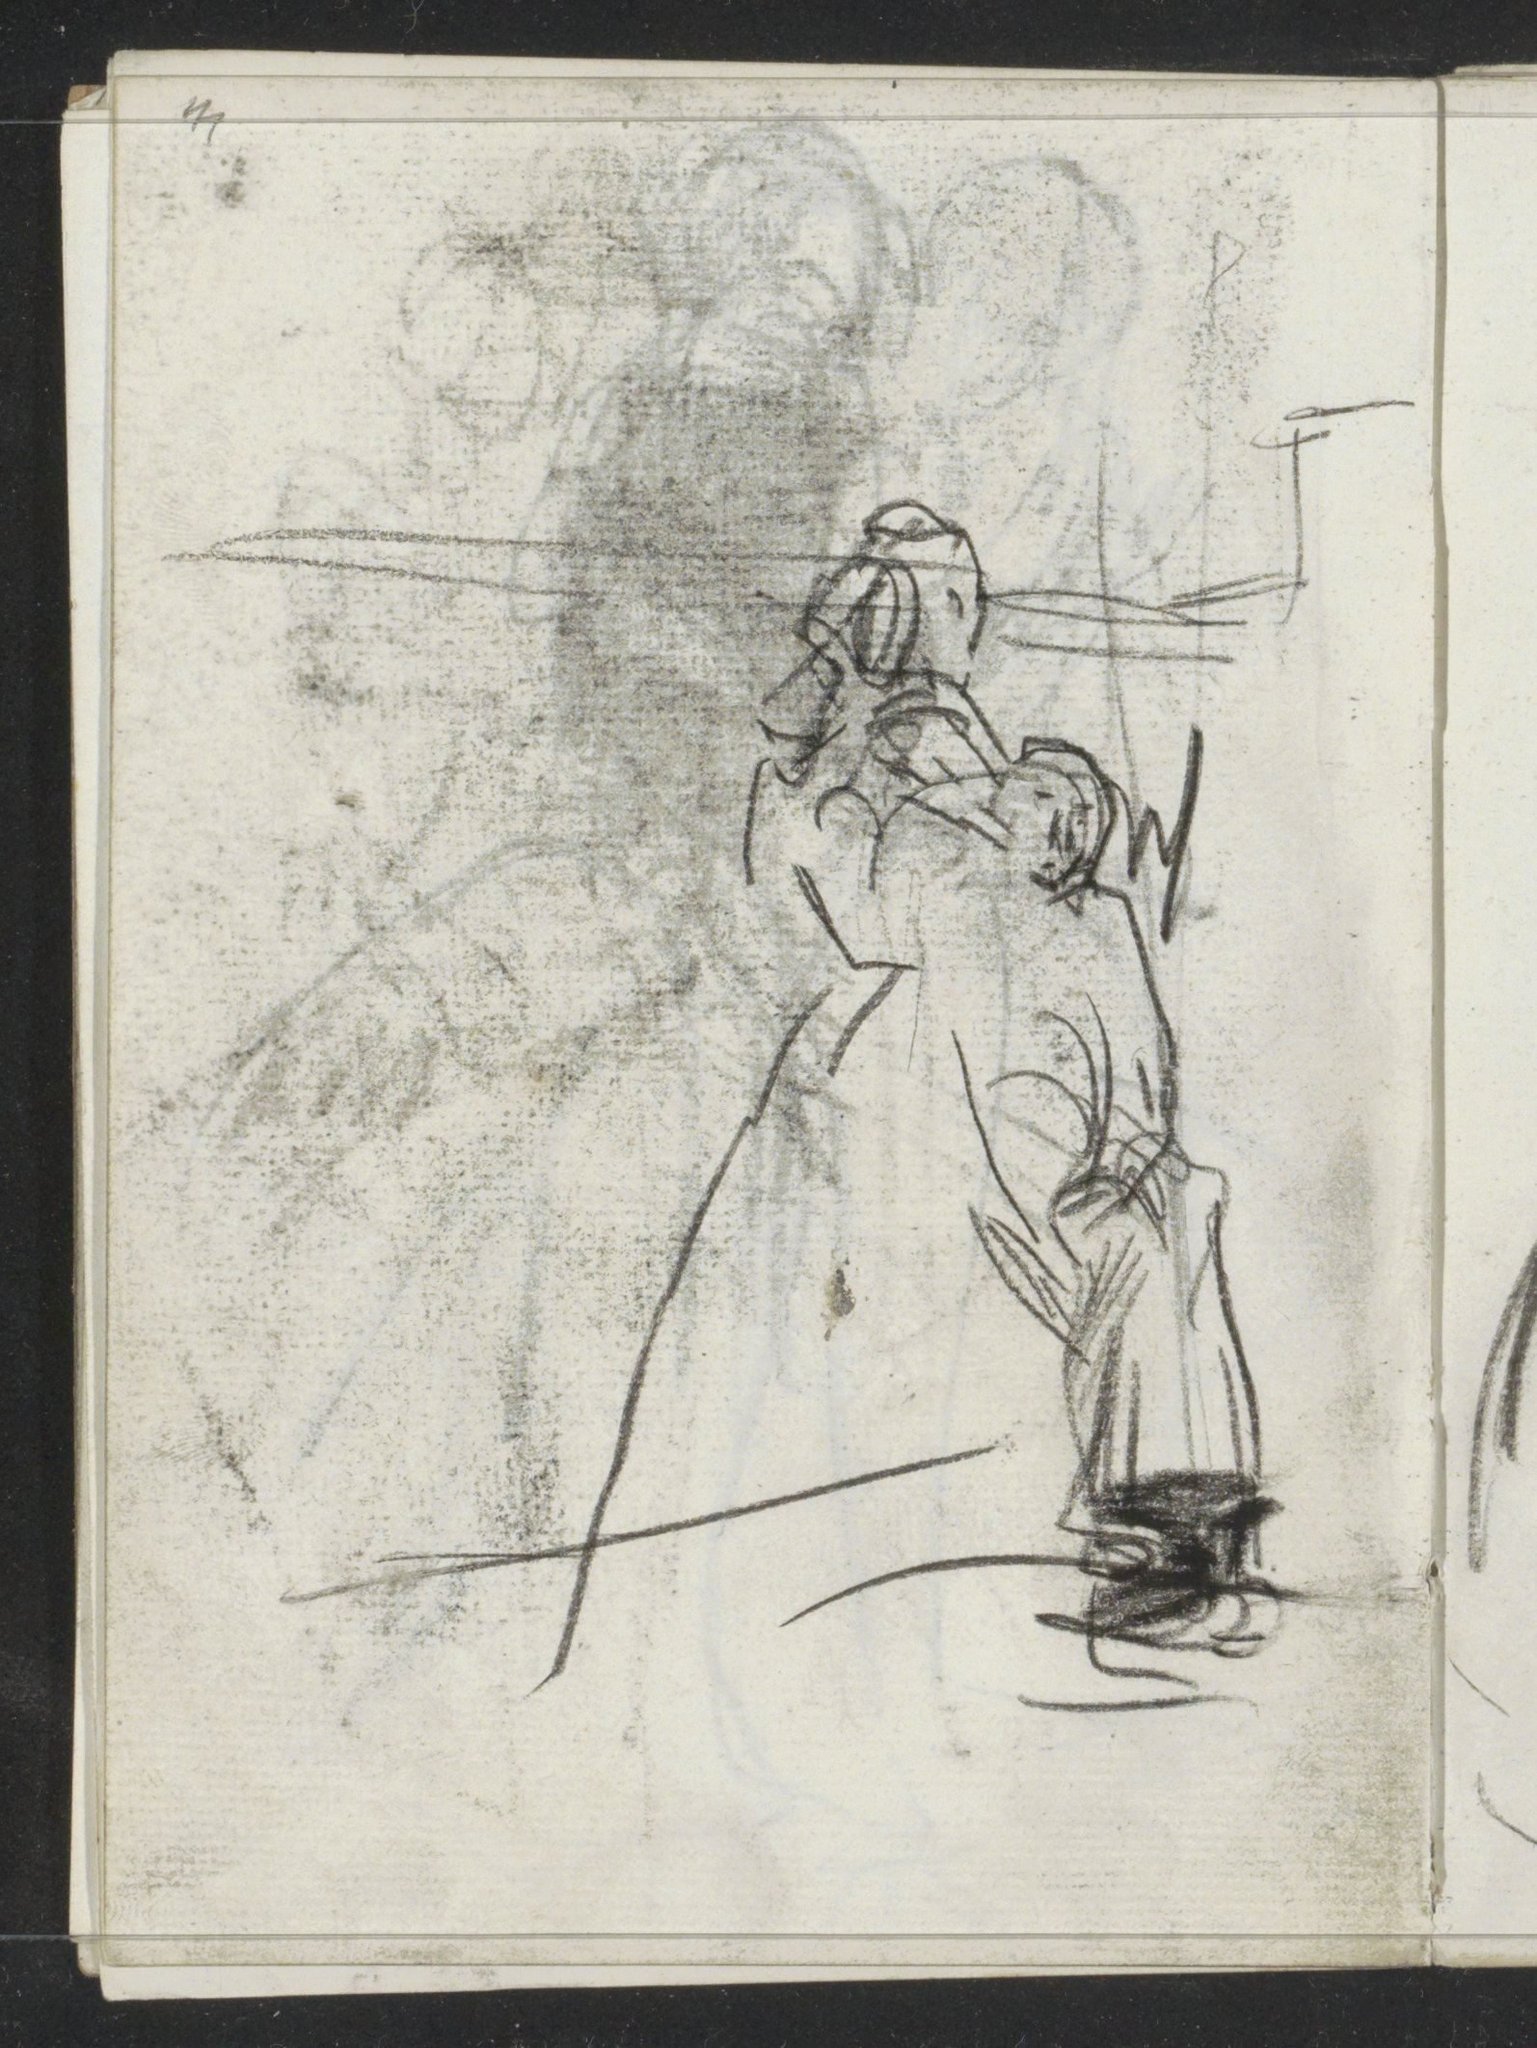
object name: sketchbook leaf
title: Staande vrouw met hoed naast een zittende vrouw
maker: isaac israels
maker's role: draughtsman, painter, print maker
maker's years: 1865-1934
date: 1886-1934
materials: chalk, paper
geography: amsterdam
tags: adult woman (+ standing), adult woman (+ sitting)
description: Blad 6 verso uit schetsboek LXIII met 23 bladen.